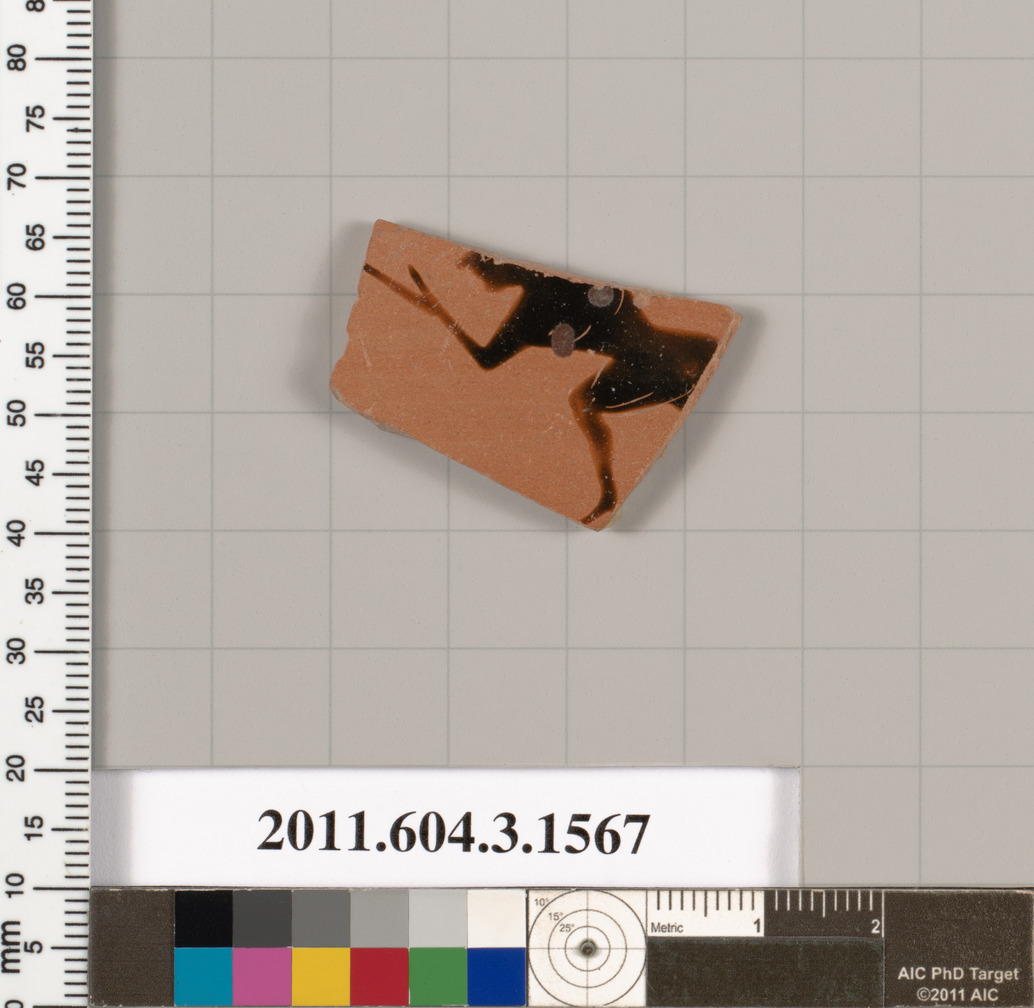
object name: kylix fragment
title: Terracotta fragment of a kylix: Band cup (drinking cup)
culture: greek, attic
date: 550-526 BCE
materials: terracotta